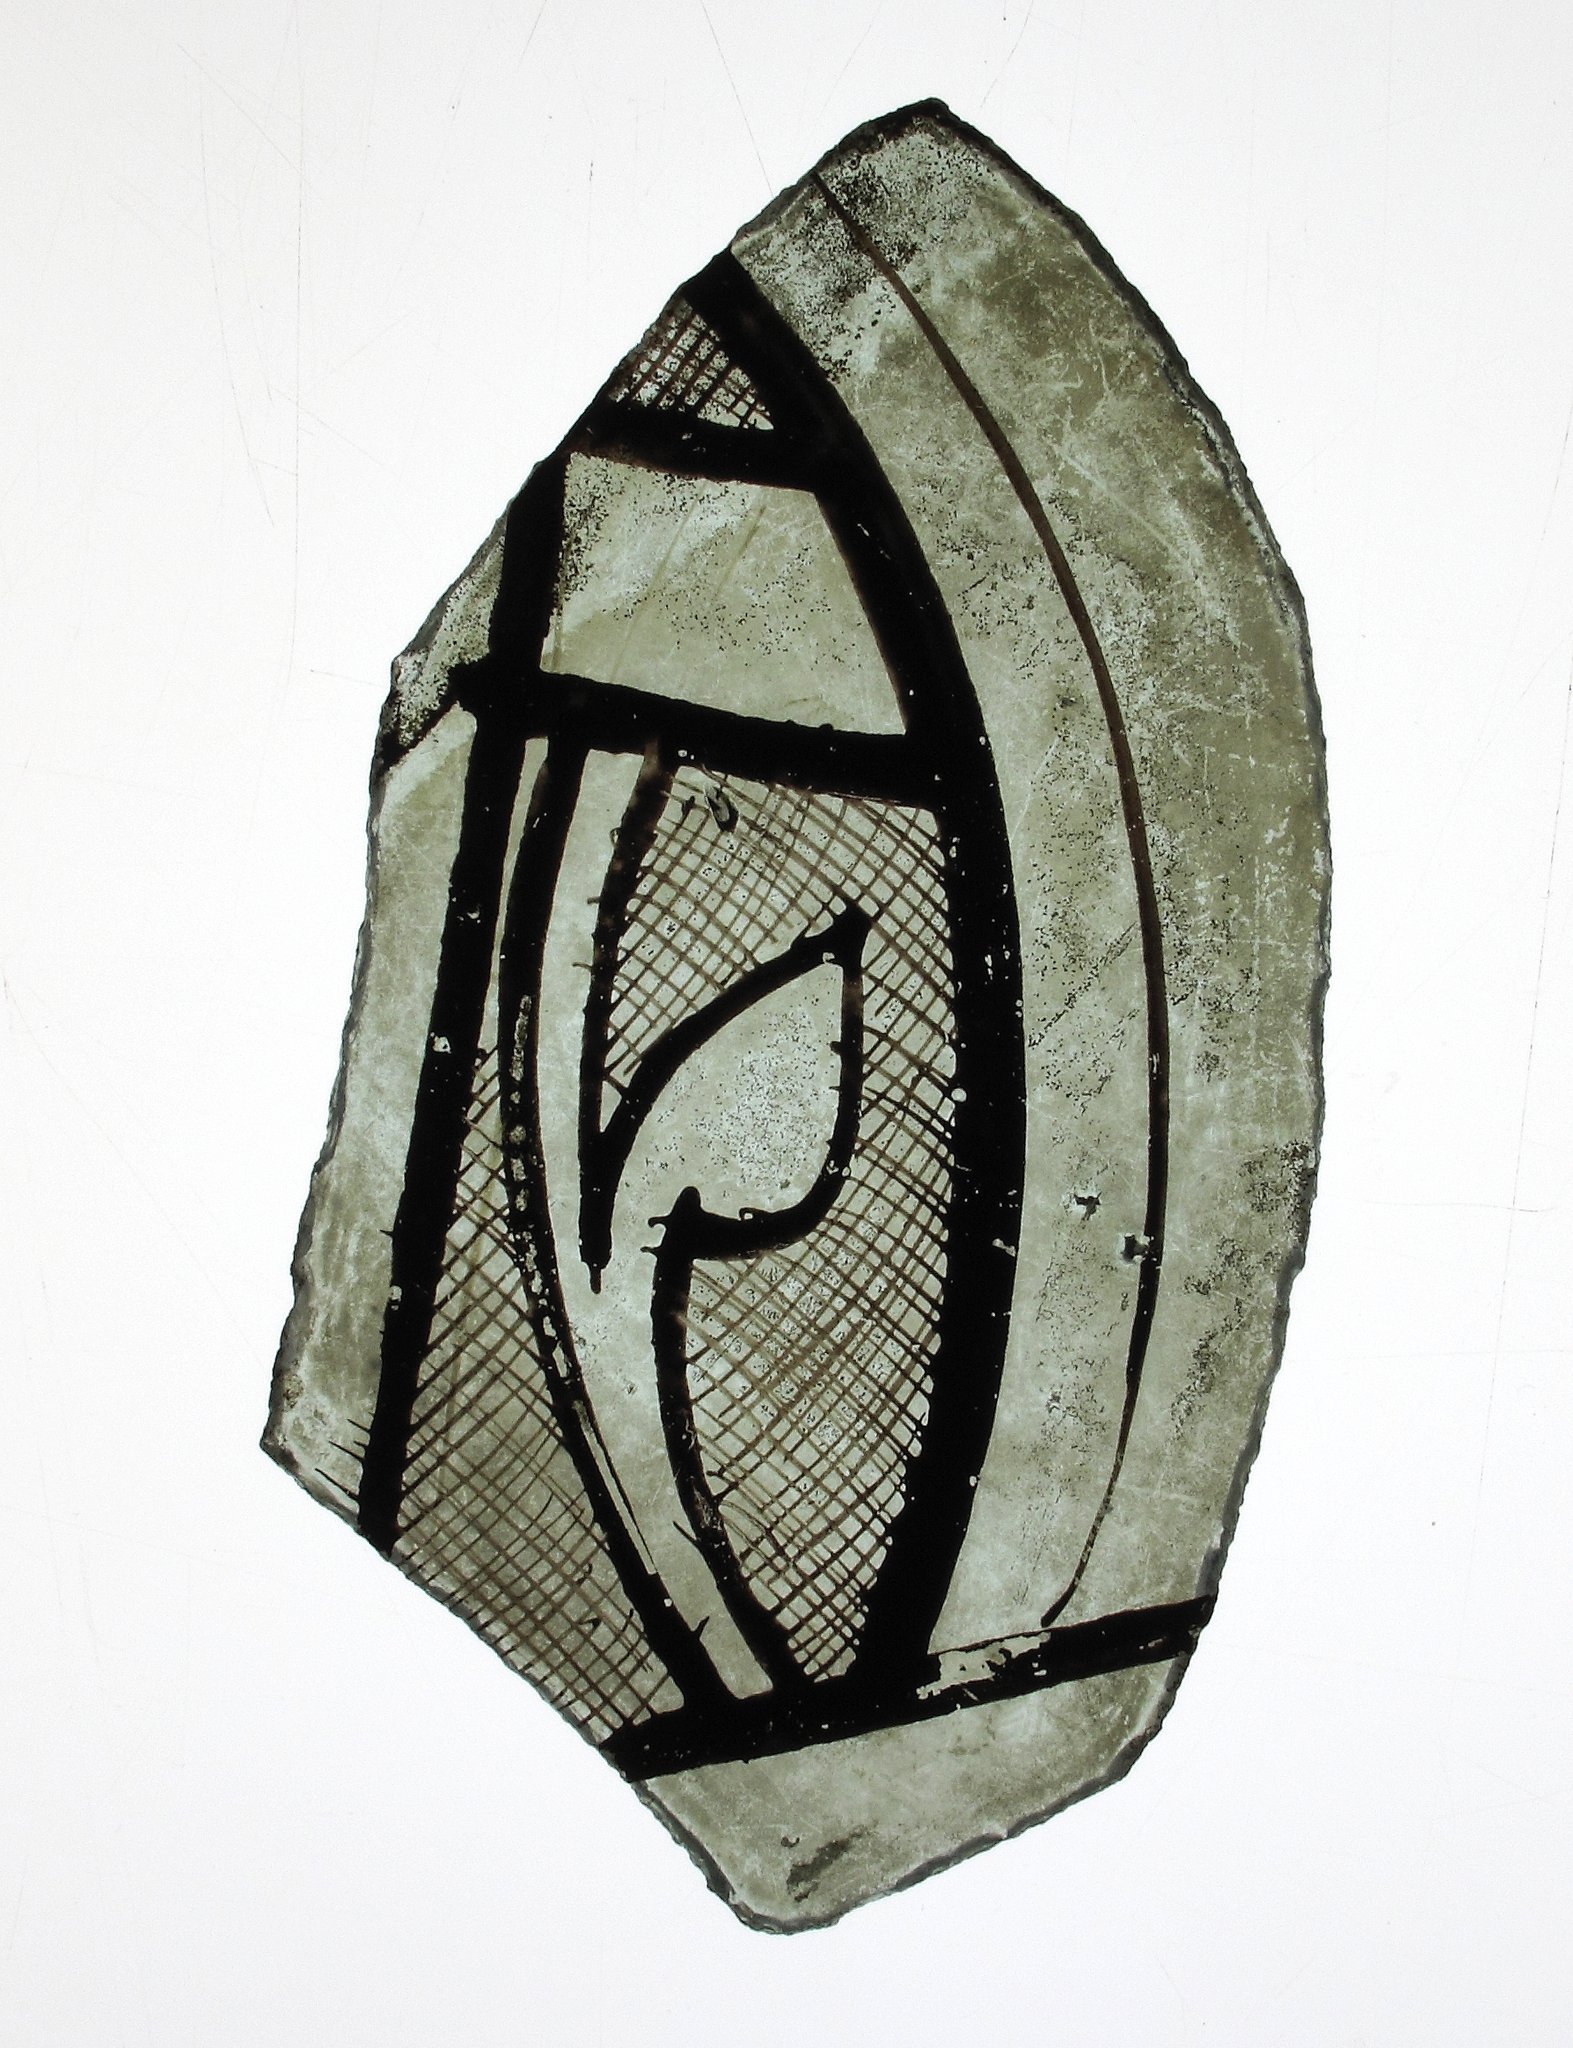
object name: fragment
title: Glass Fragment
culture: french or british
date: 1300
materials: glass